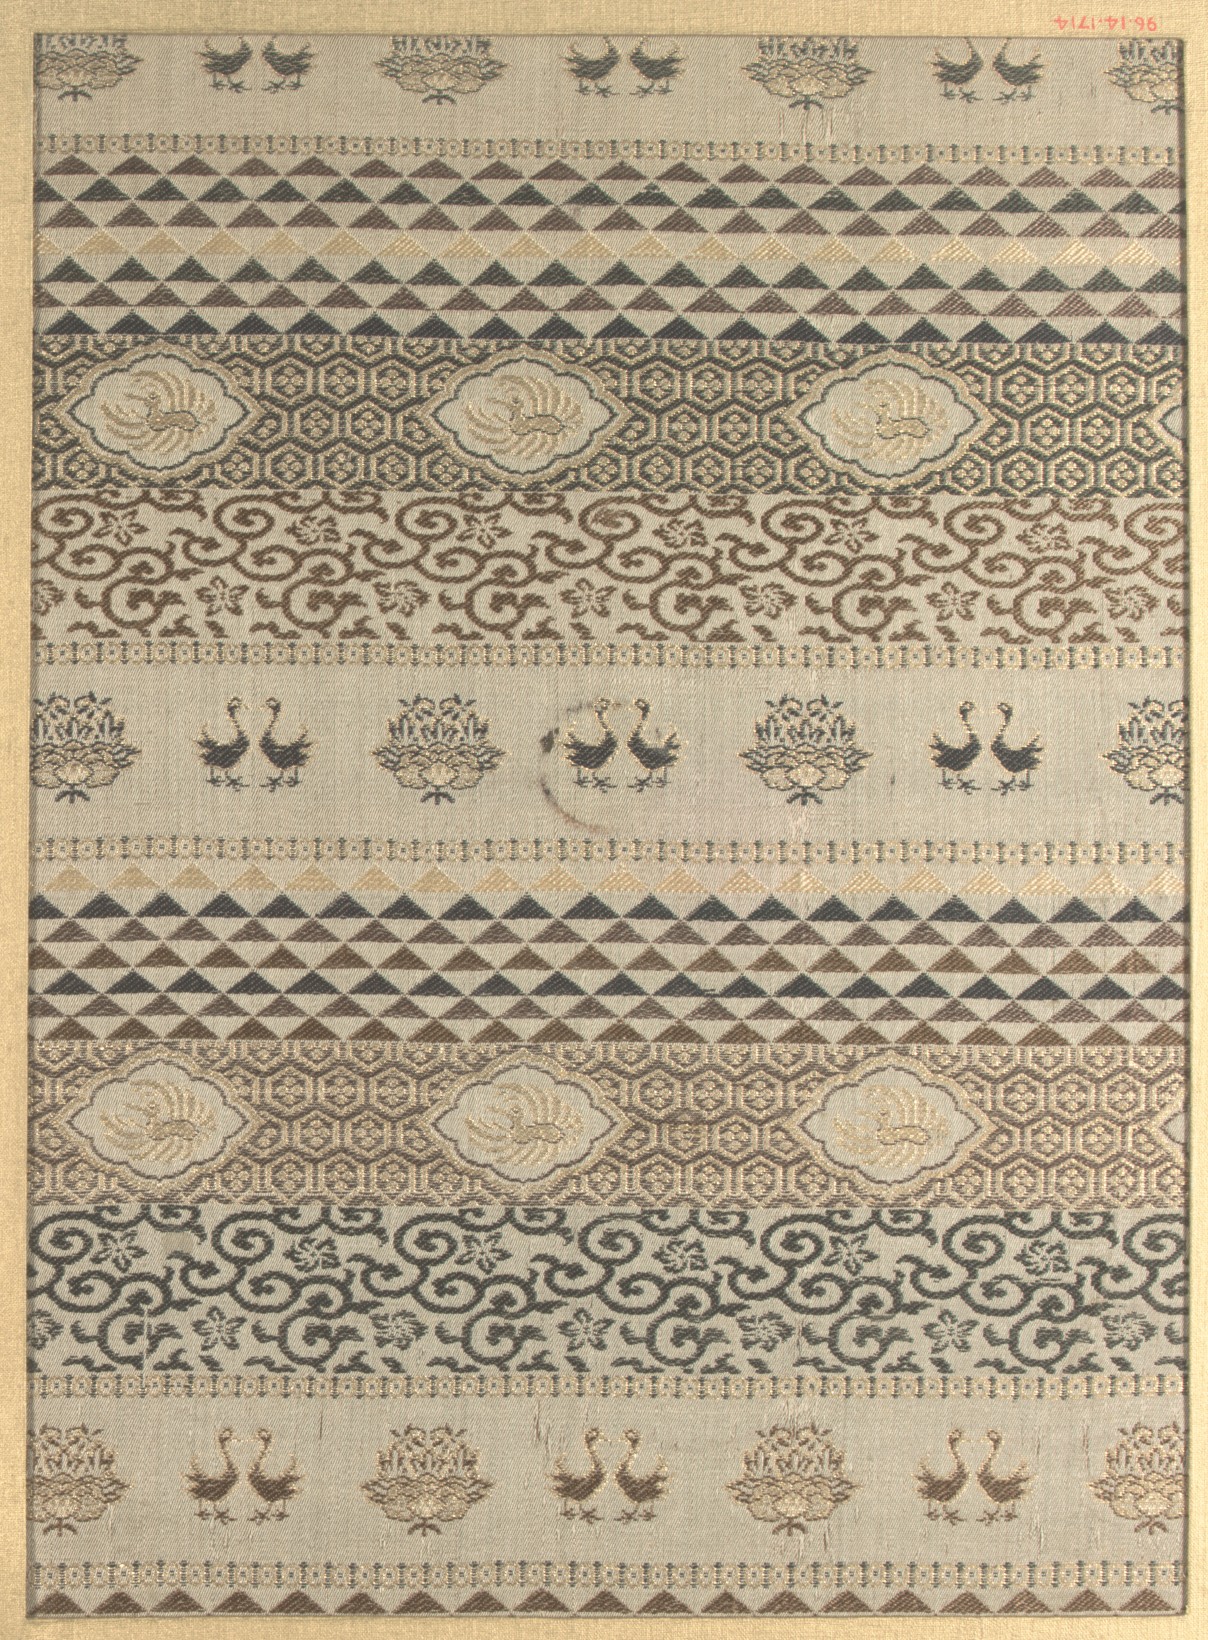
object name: piece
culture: japanese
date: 1701-1900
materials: silk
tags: birds